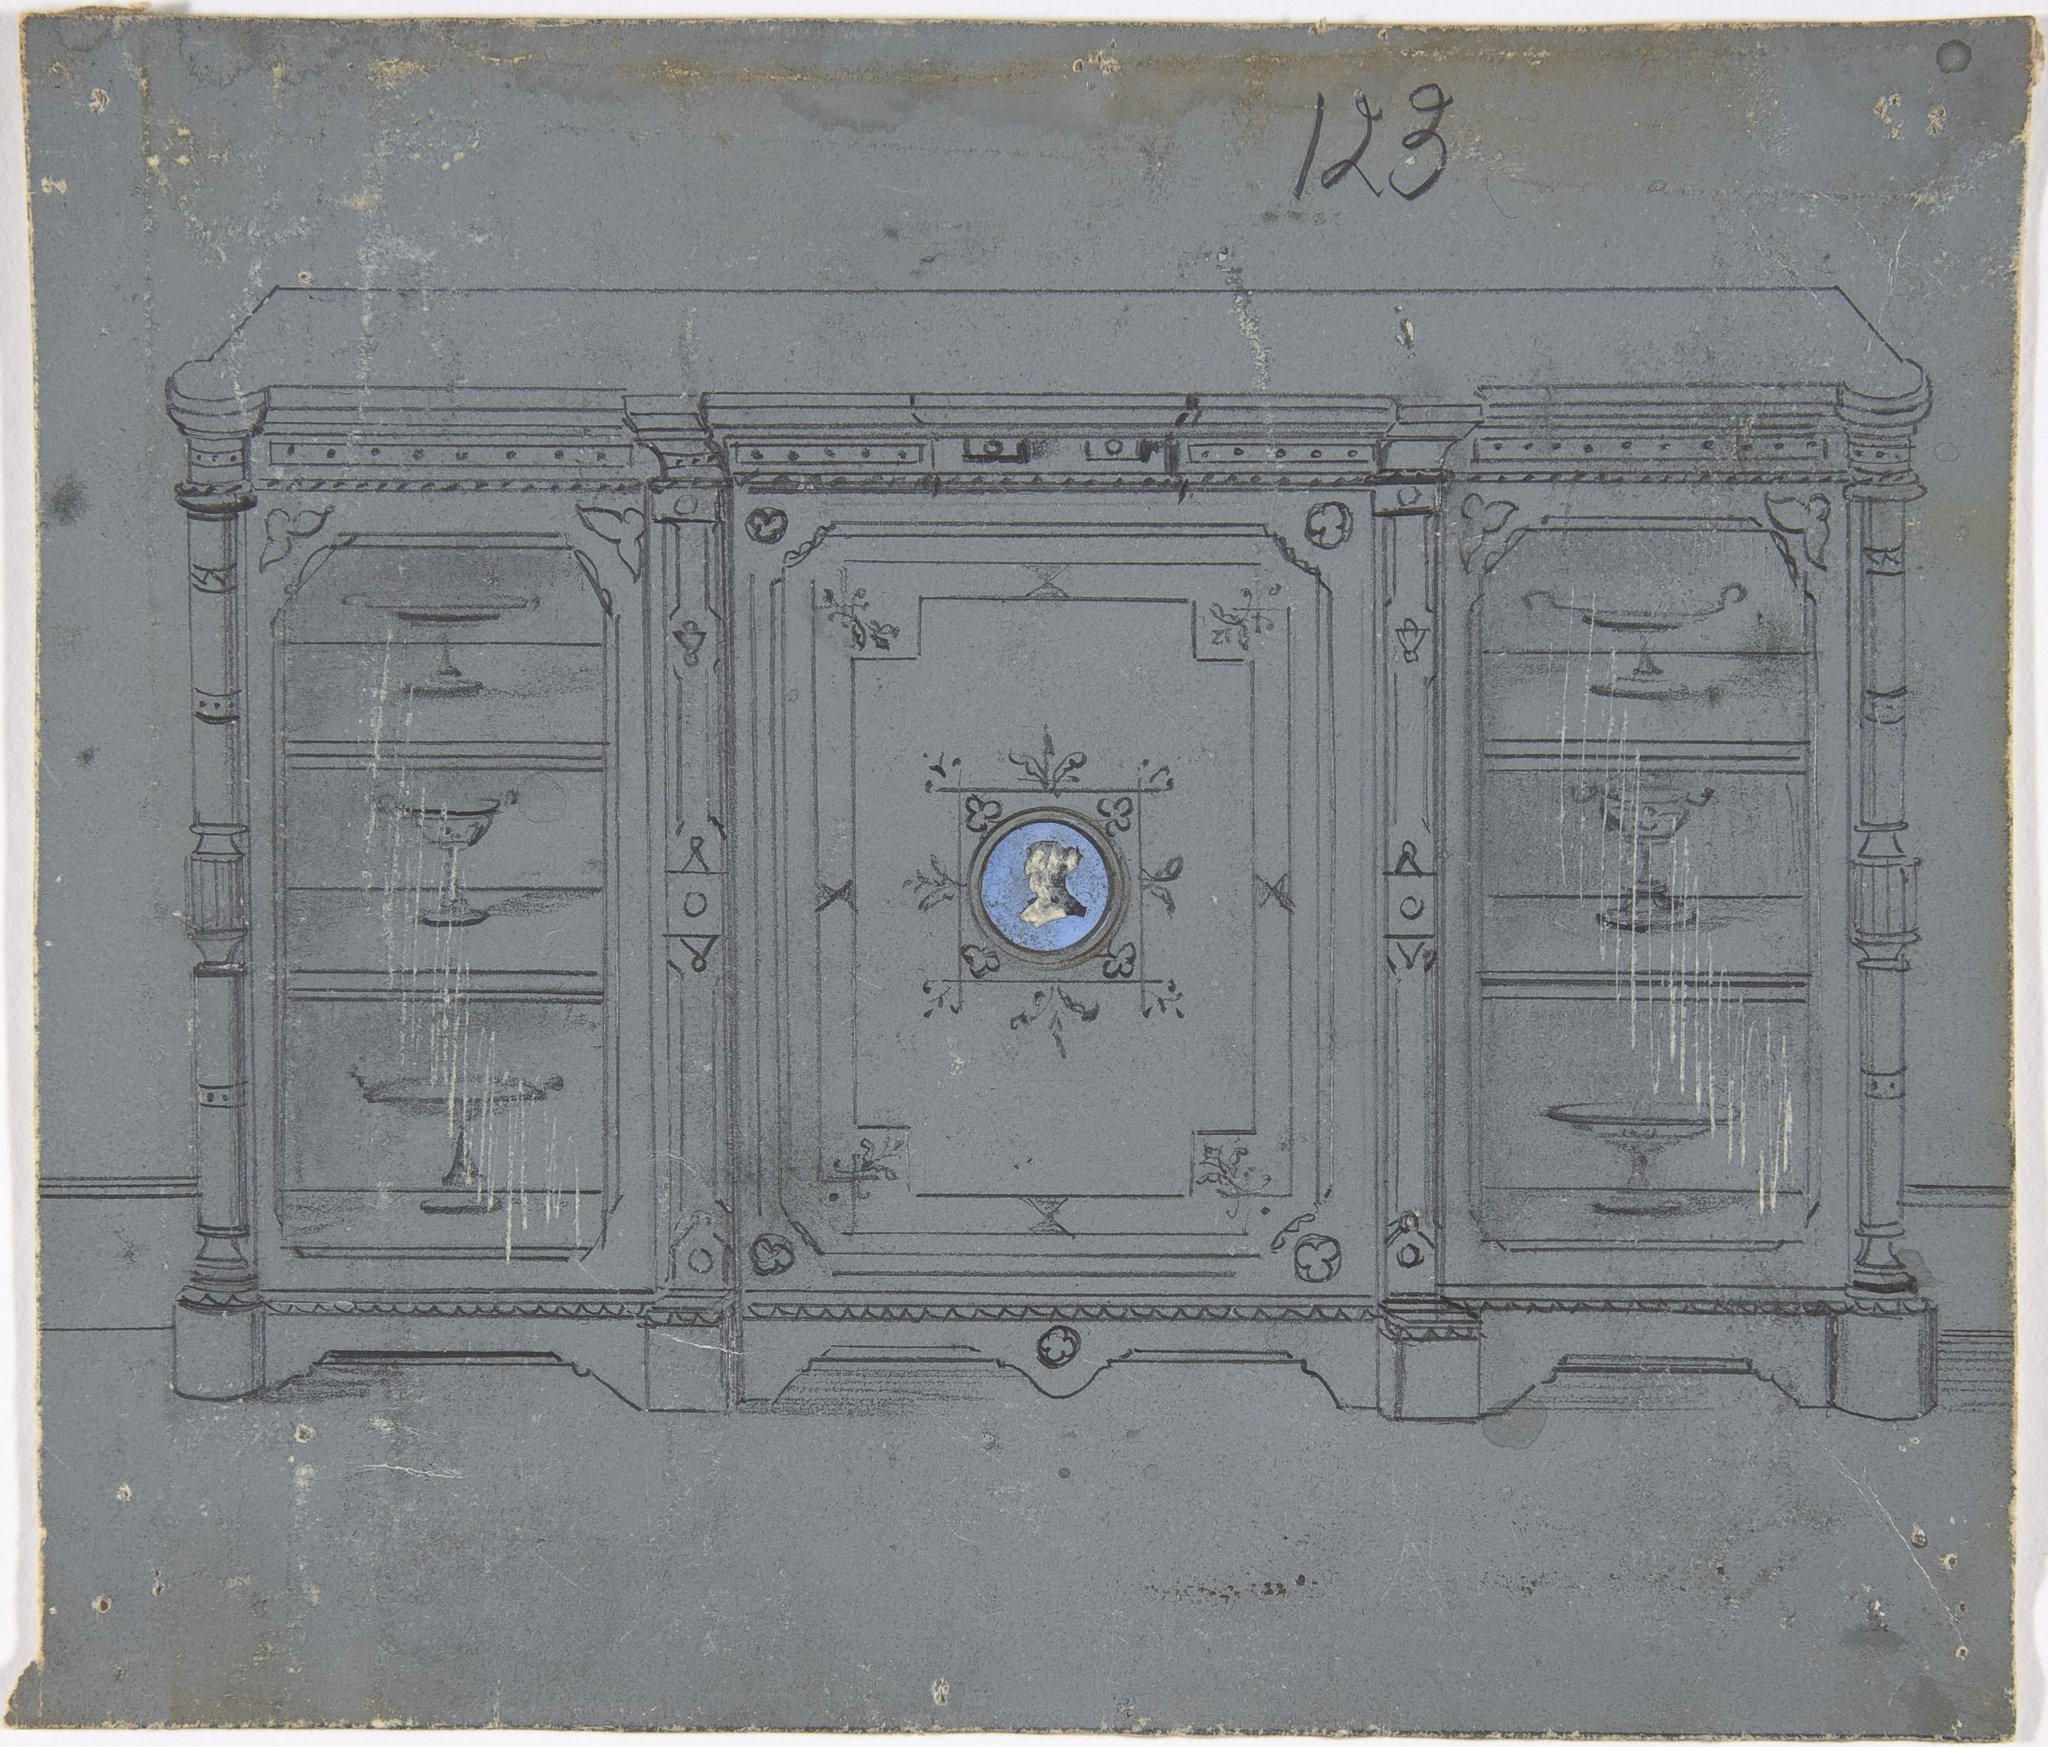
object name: drawing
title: Design for a Cabinet witha Porcelain Plaque on the Center Panel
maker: anonymous, british, 19th century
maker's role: artist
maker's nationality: british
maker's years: 1800-1900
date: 1801-1900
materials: graphite, watercolor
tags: cabinets